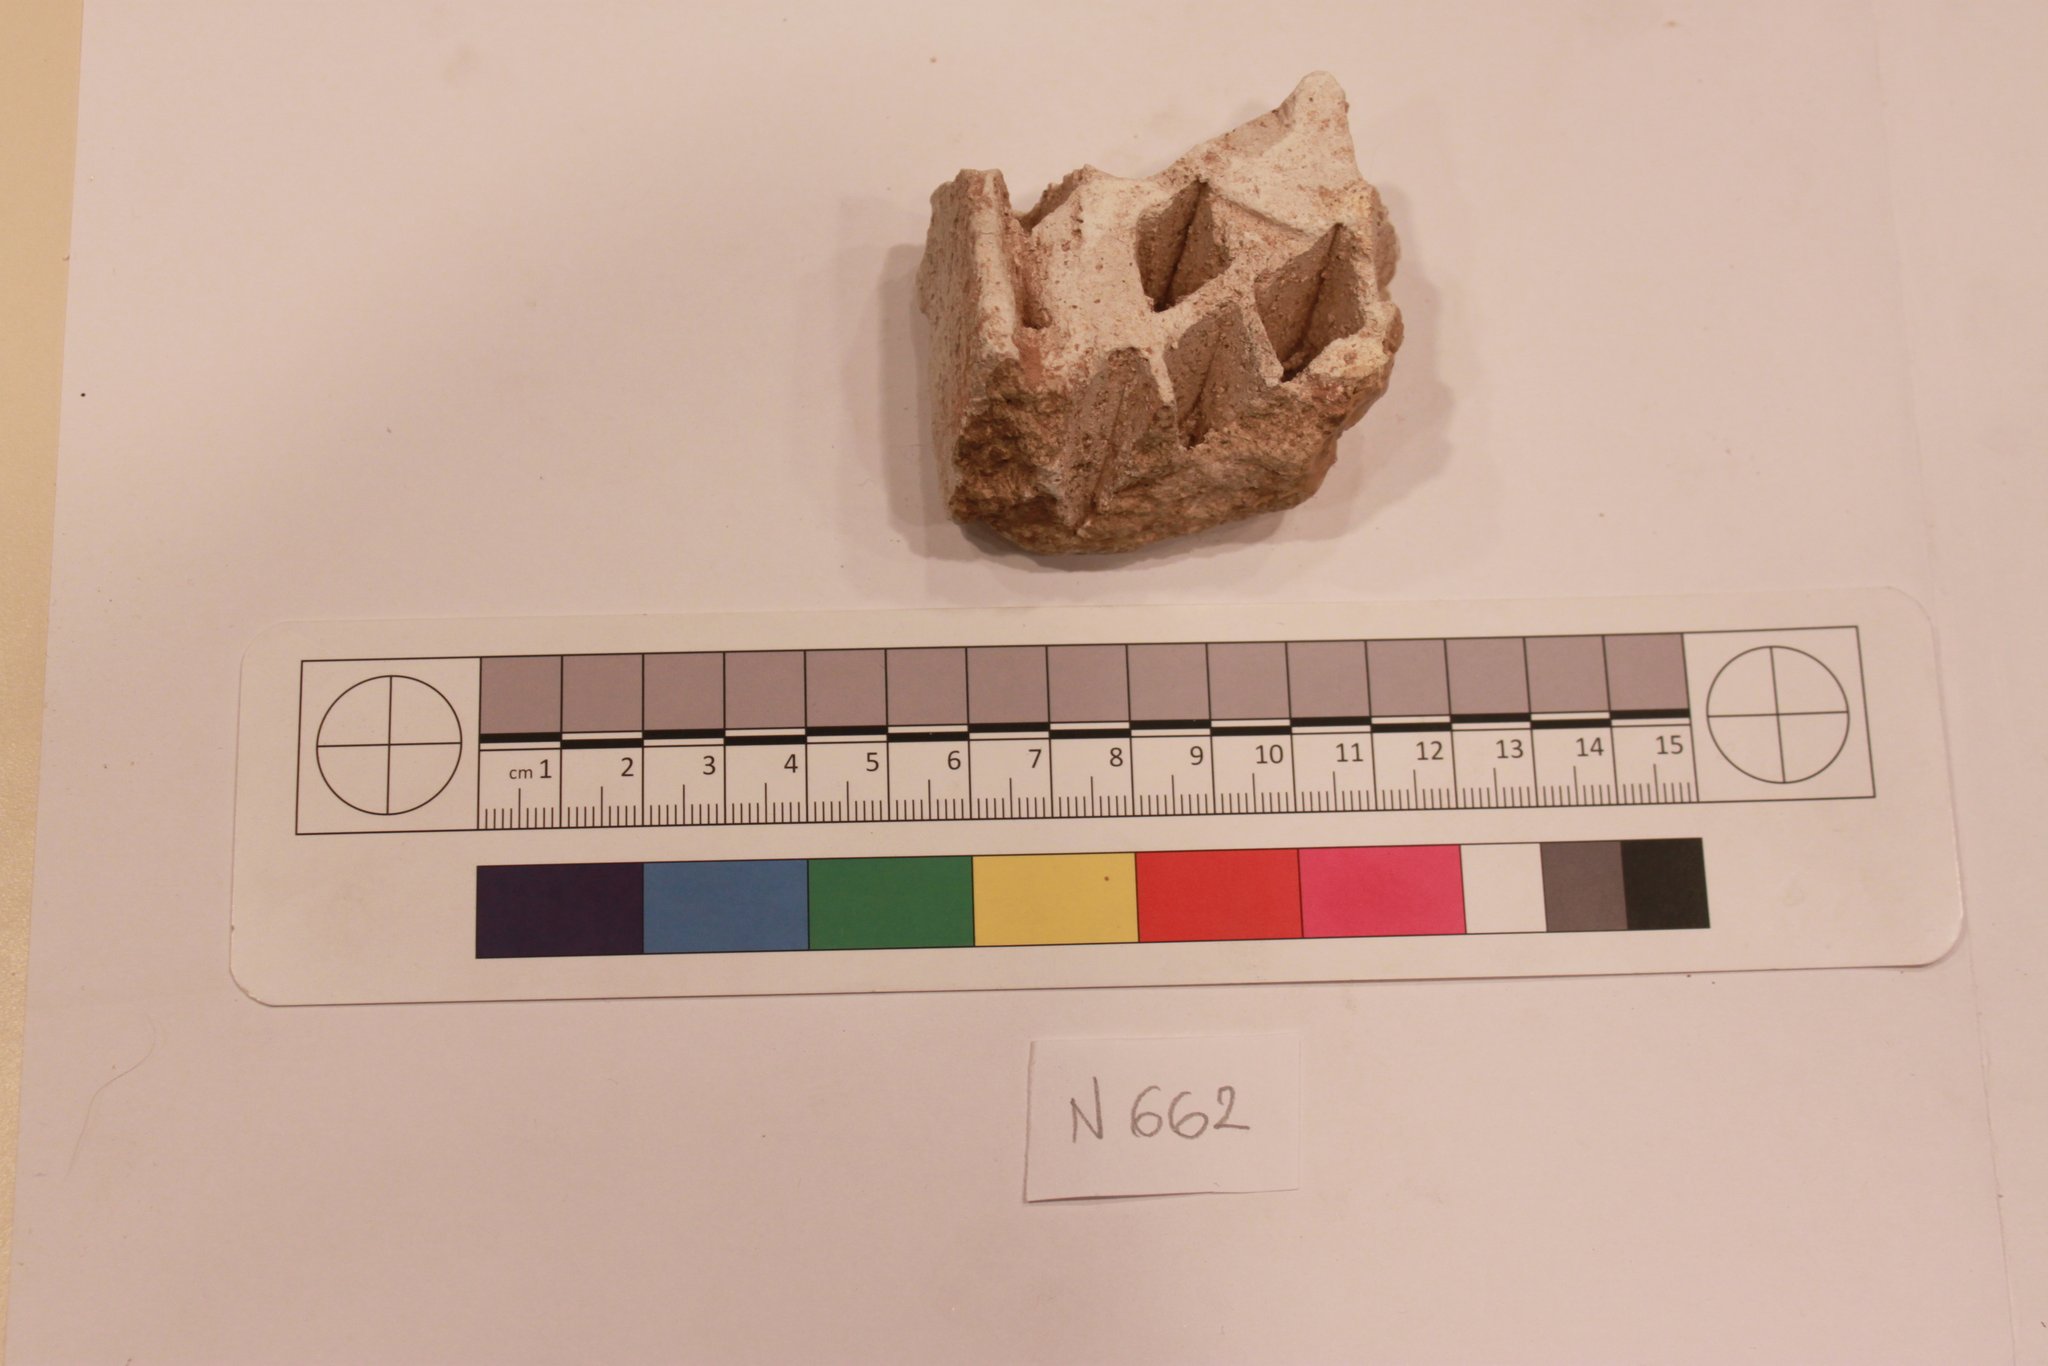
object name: fragment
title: Stucco Fragment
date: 701-1200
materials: plaster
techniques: carving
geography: iran